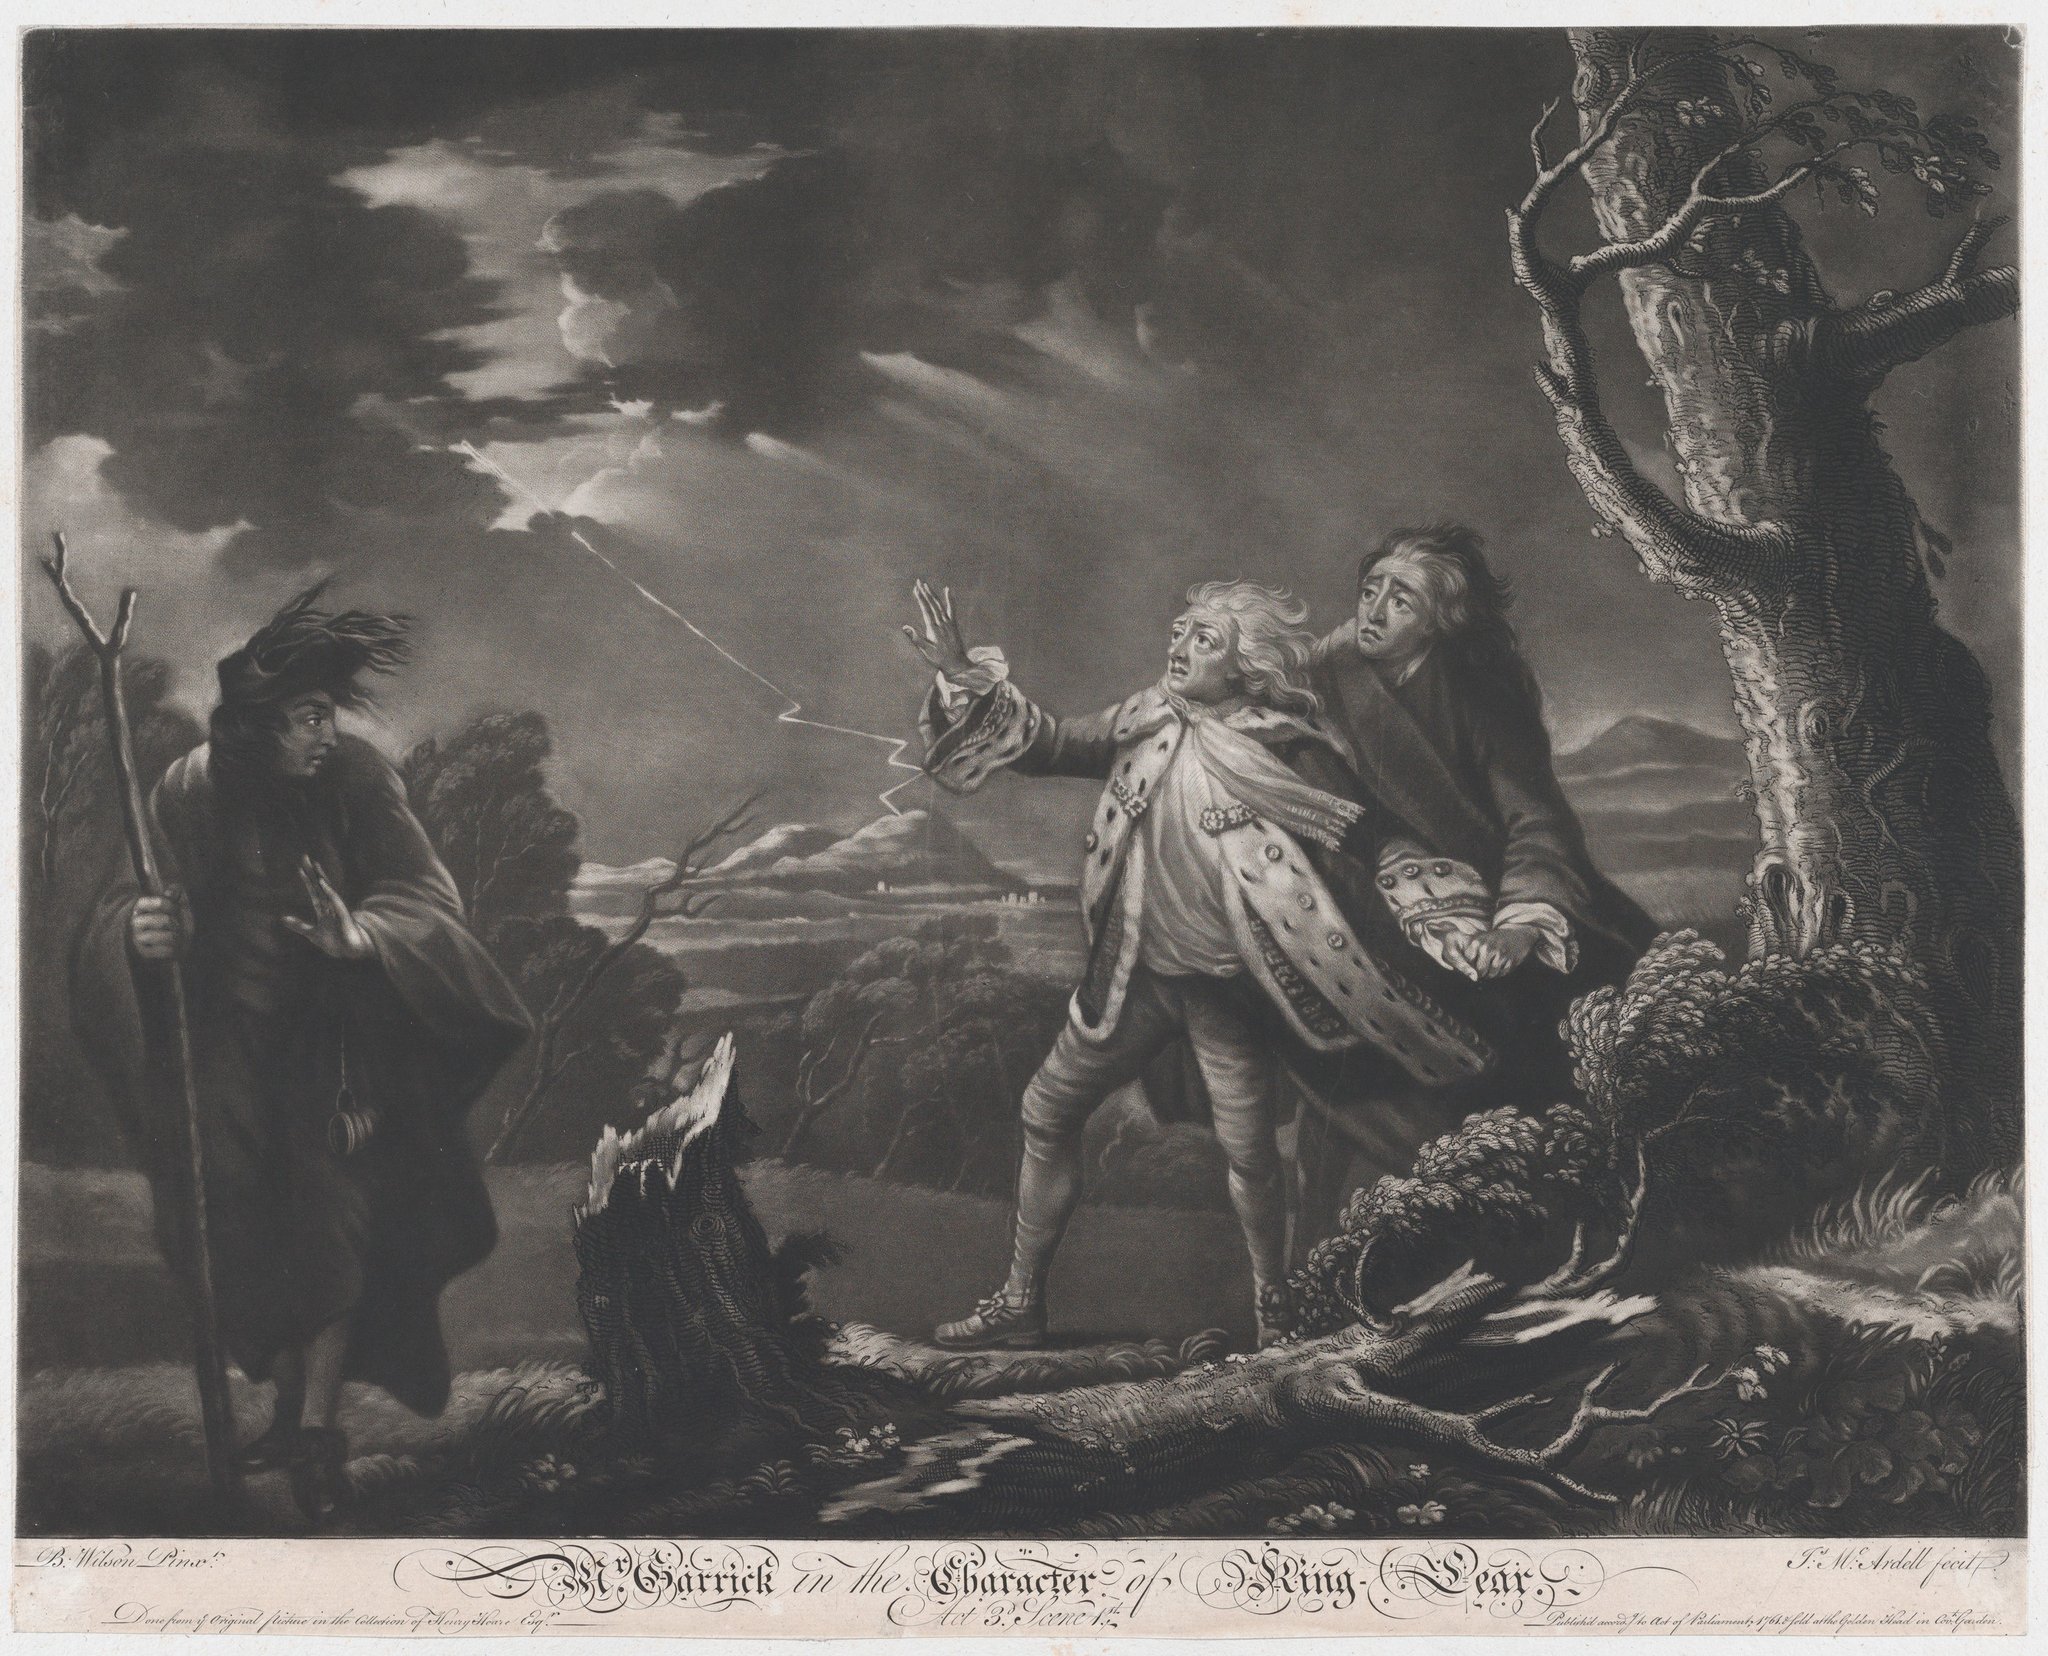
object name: print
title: Mr. Garrick in the Character of King Lear (Shakespeare, King Lear, Act 3, Scene 1)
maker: james mcardell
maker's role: engraver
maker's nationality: irish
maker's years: 1728-1765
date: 1761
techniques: mezzotint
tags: shakespeare,men,women,king lear